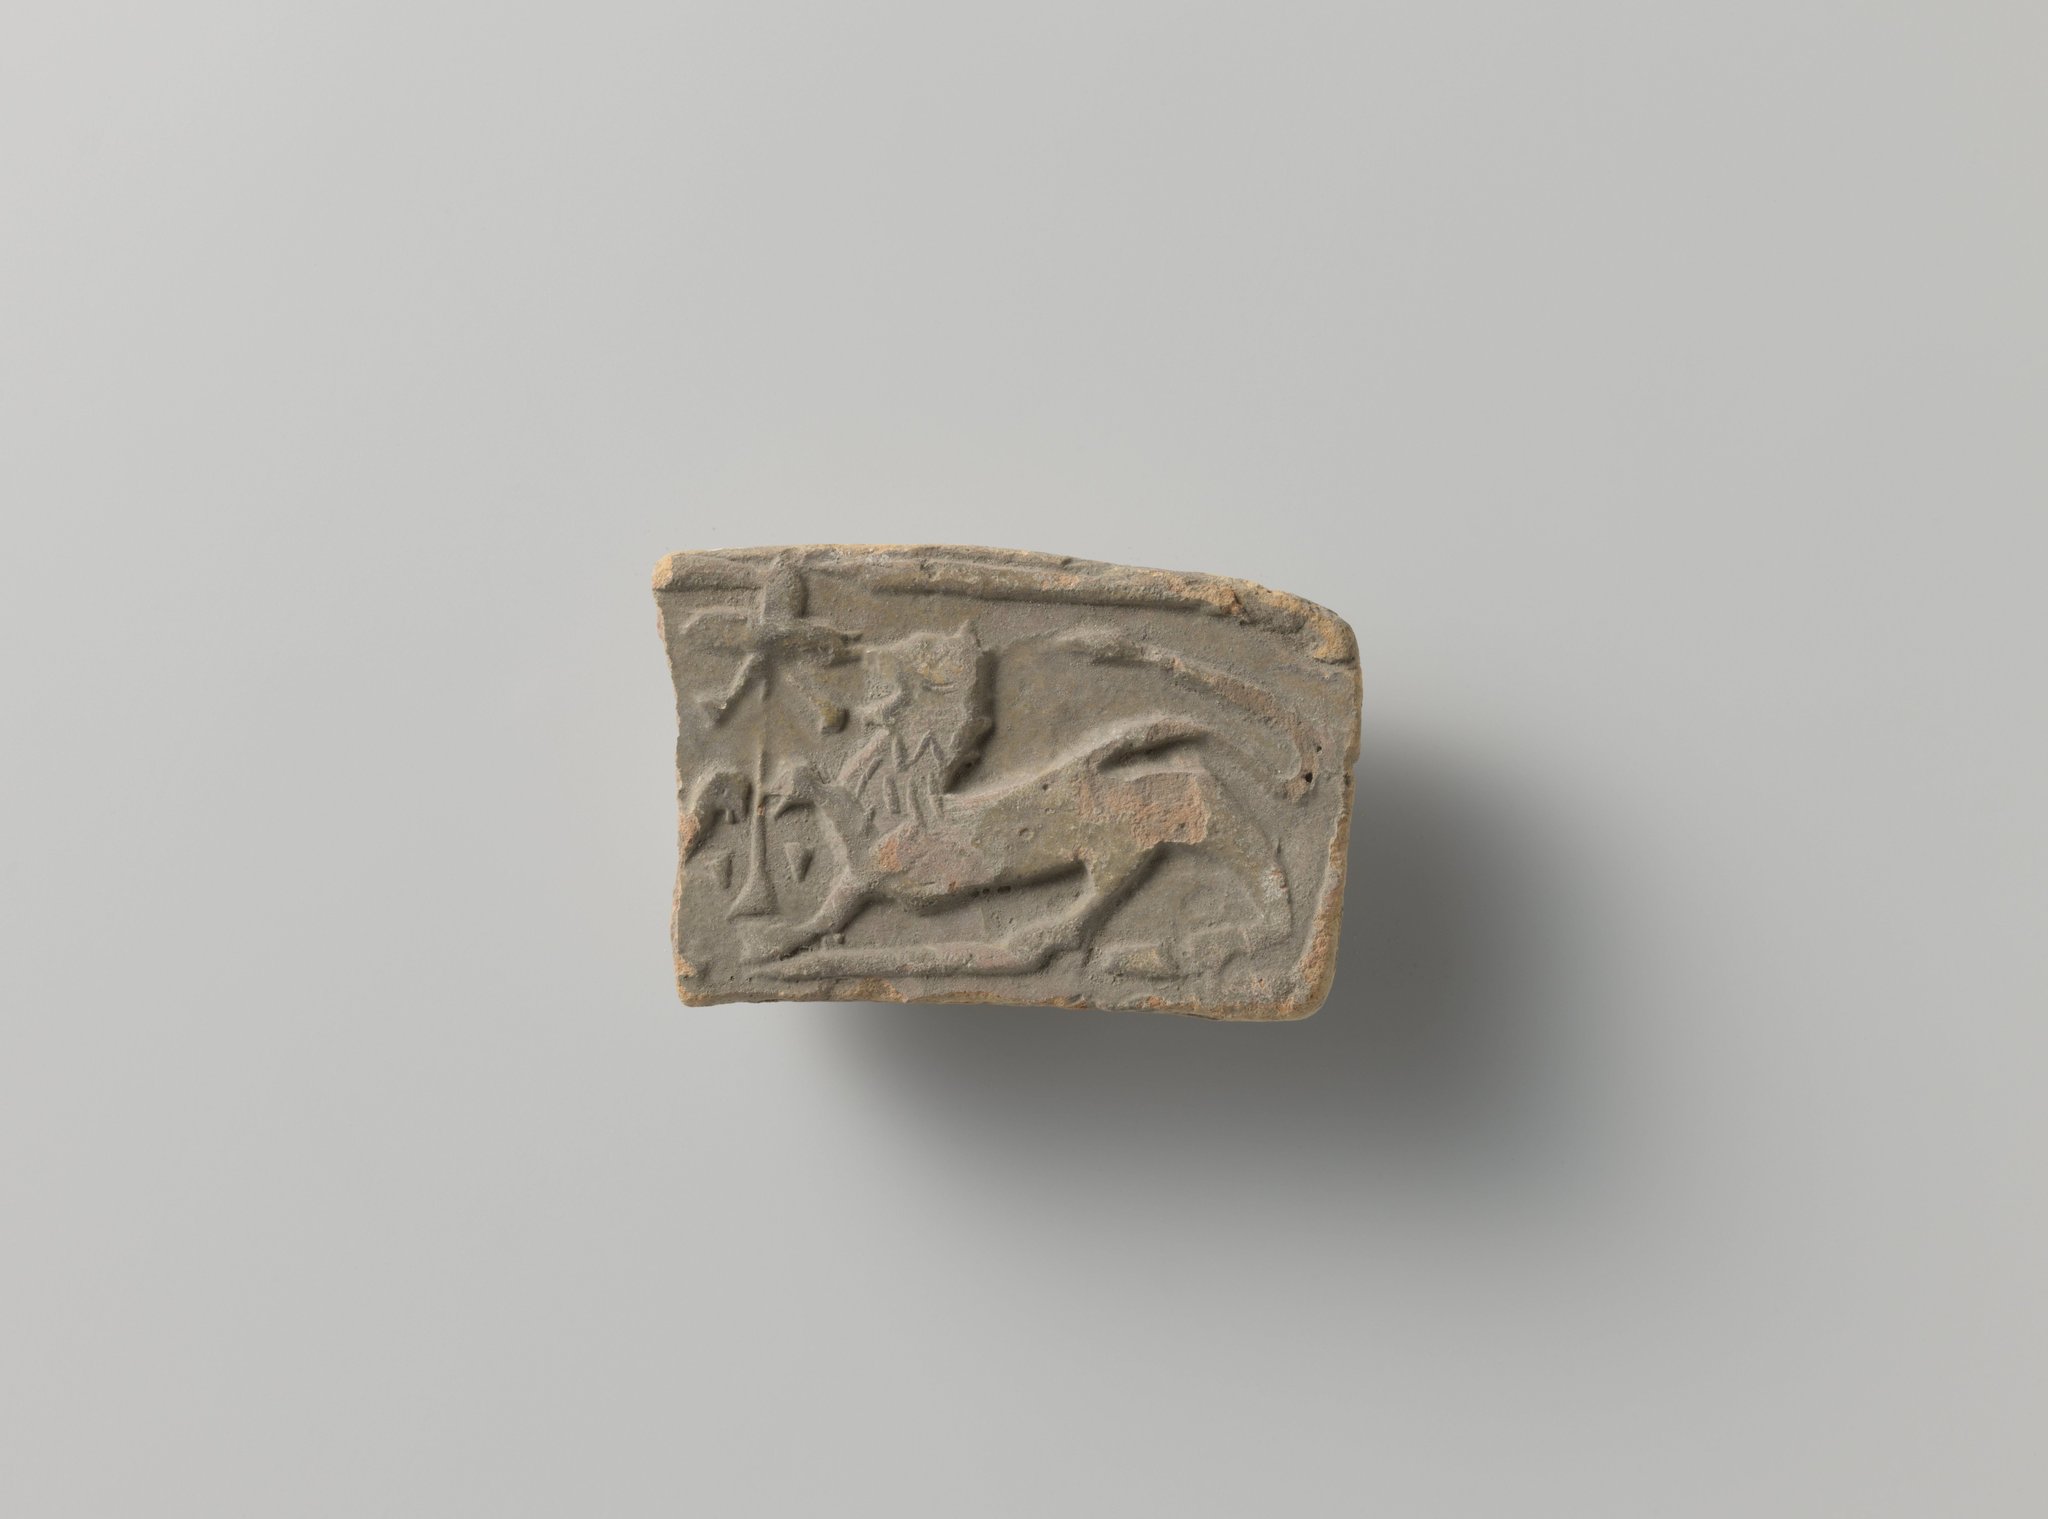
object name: hearthstone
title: Haardsteen met afbeelding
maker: Anonymous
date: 1400-1950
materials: earthenware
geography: southern netherlands